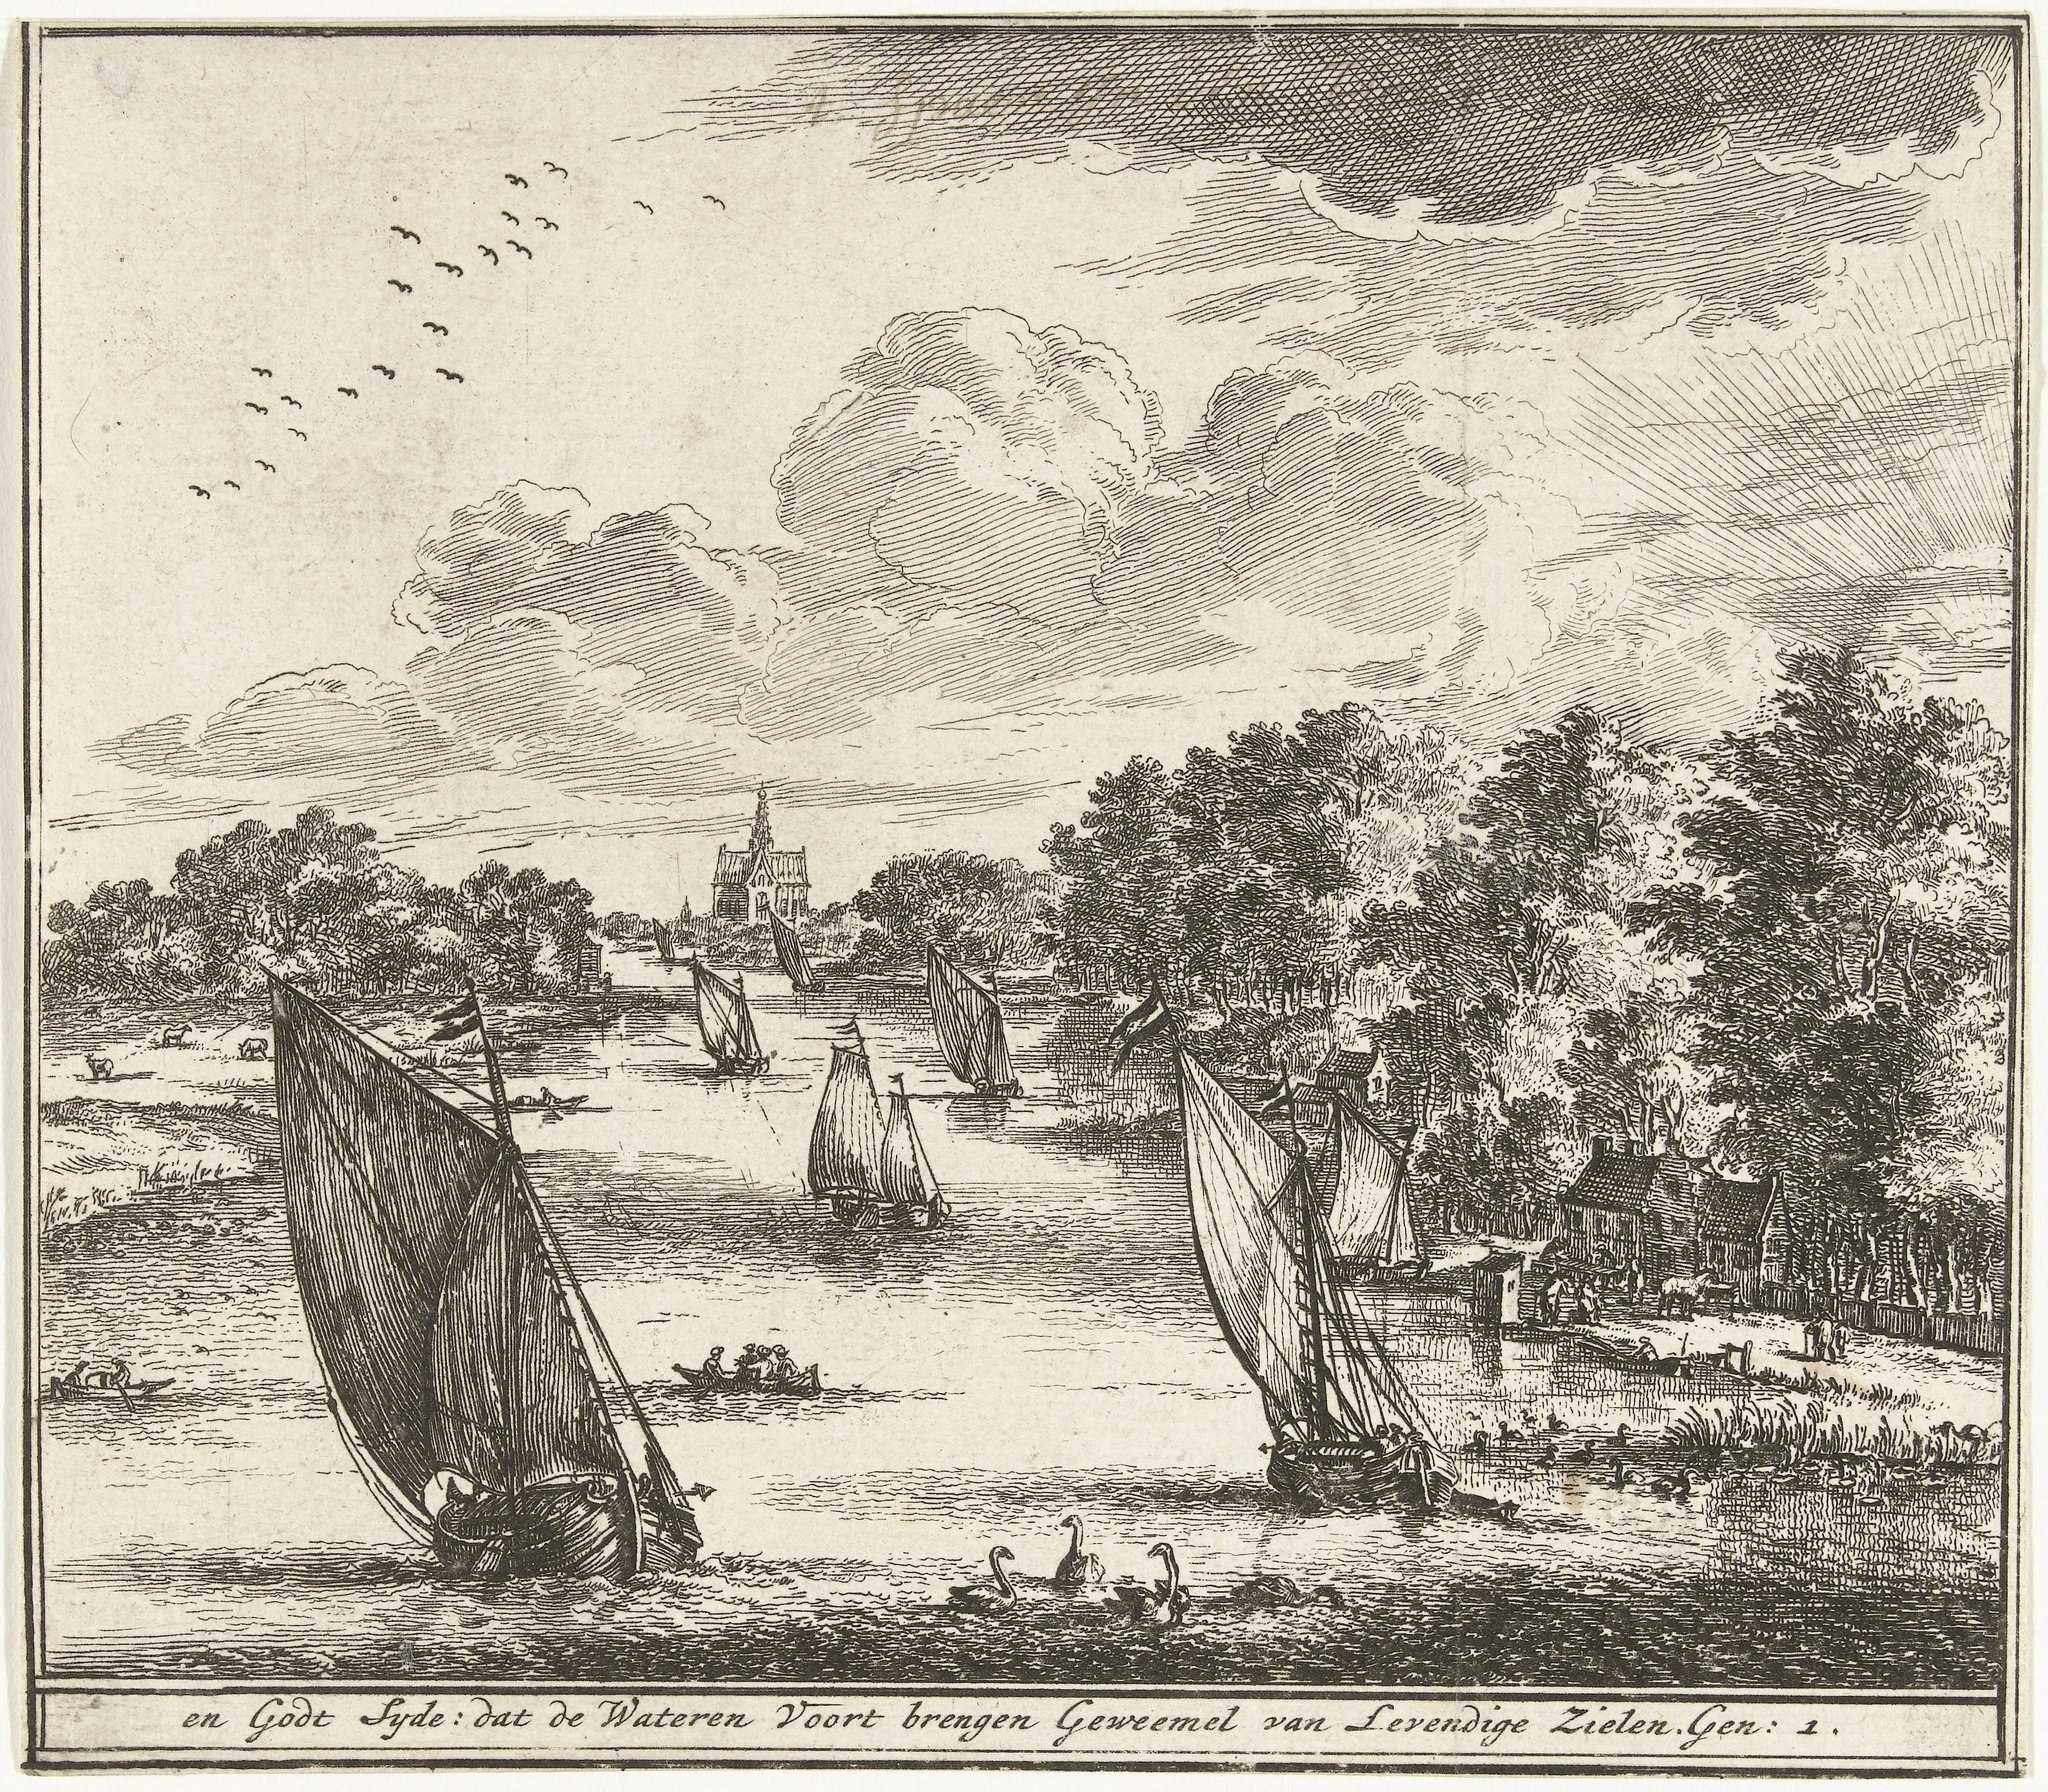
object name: book illustration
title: Riviergezicht met zeilschepen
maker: coenraet decker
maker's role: print maker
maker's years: 1650-1685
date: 1685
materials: paper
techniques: etching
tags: sailing-ship, sailing-boat, river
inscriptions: collector's mark: Lugt 240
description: Prent uit: Jan van Westerhoven, Den schepper verheerlijckt in de schepselen, ofte Choor-gesang, aller geschapene dingen, Haarlem, J.G. Geldrop (uitgever), 1685